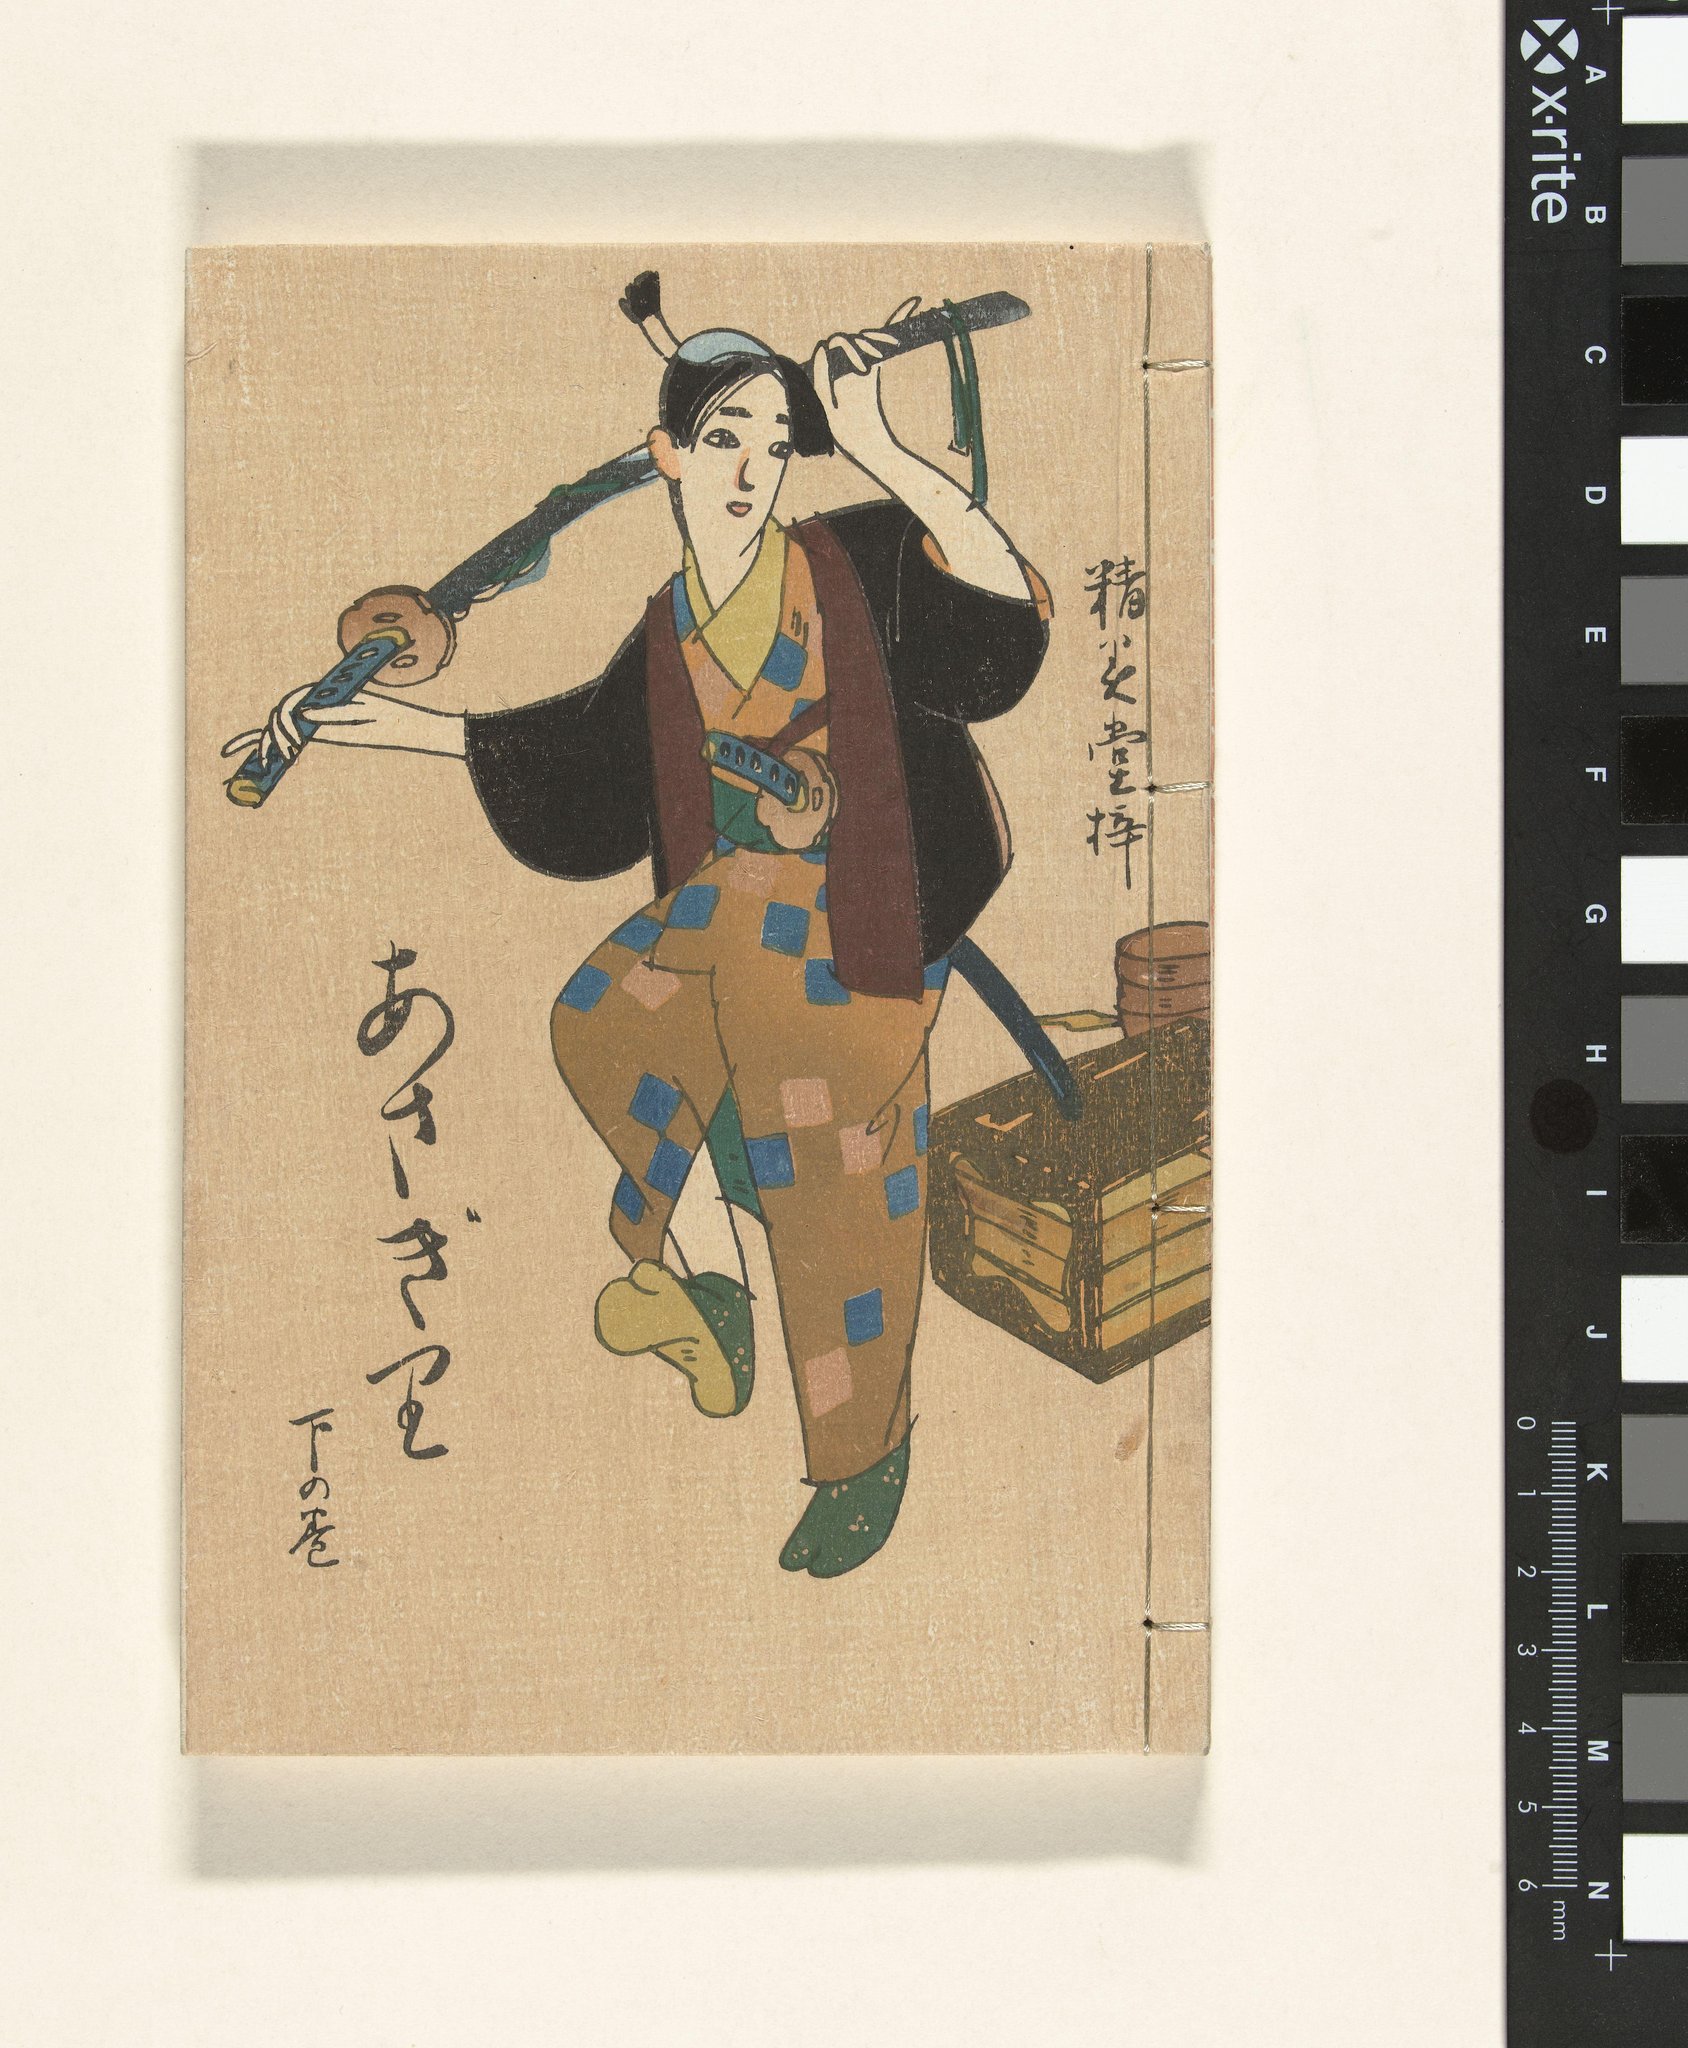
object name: book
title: Asagiri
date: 1902-1912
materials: paper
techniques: woodcut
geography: tokyo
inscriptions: collector's mark: Lugt 2228